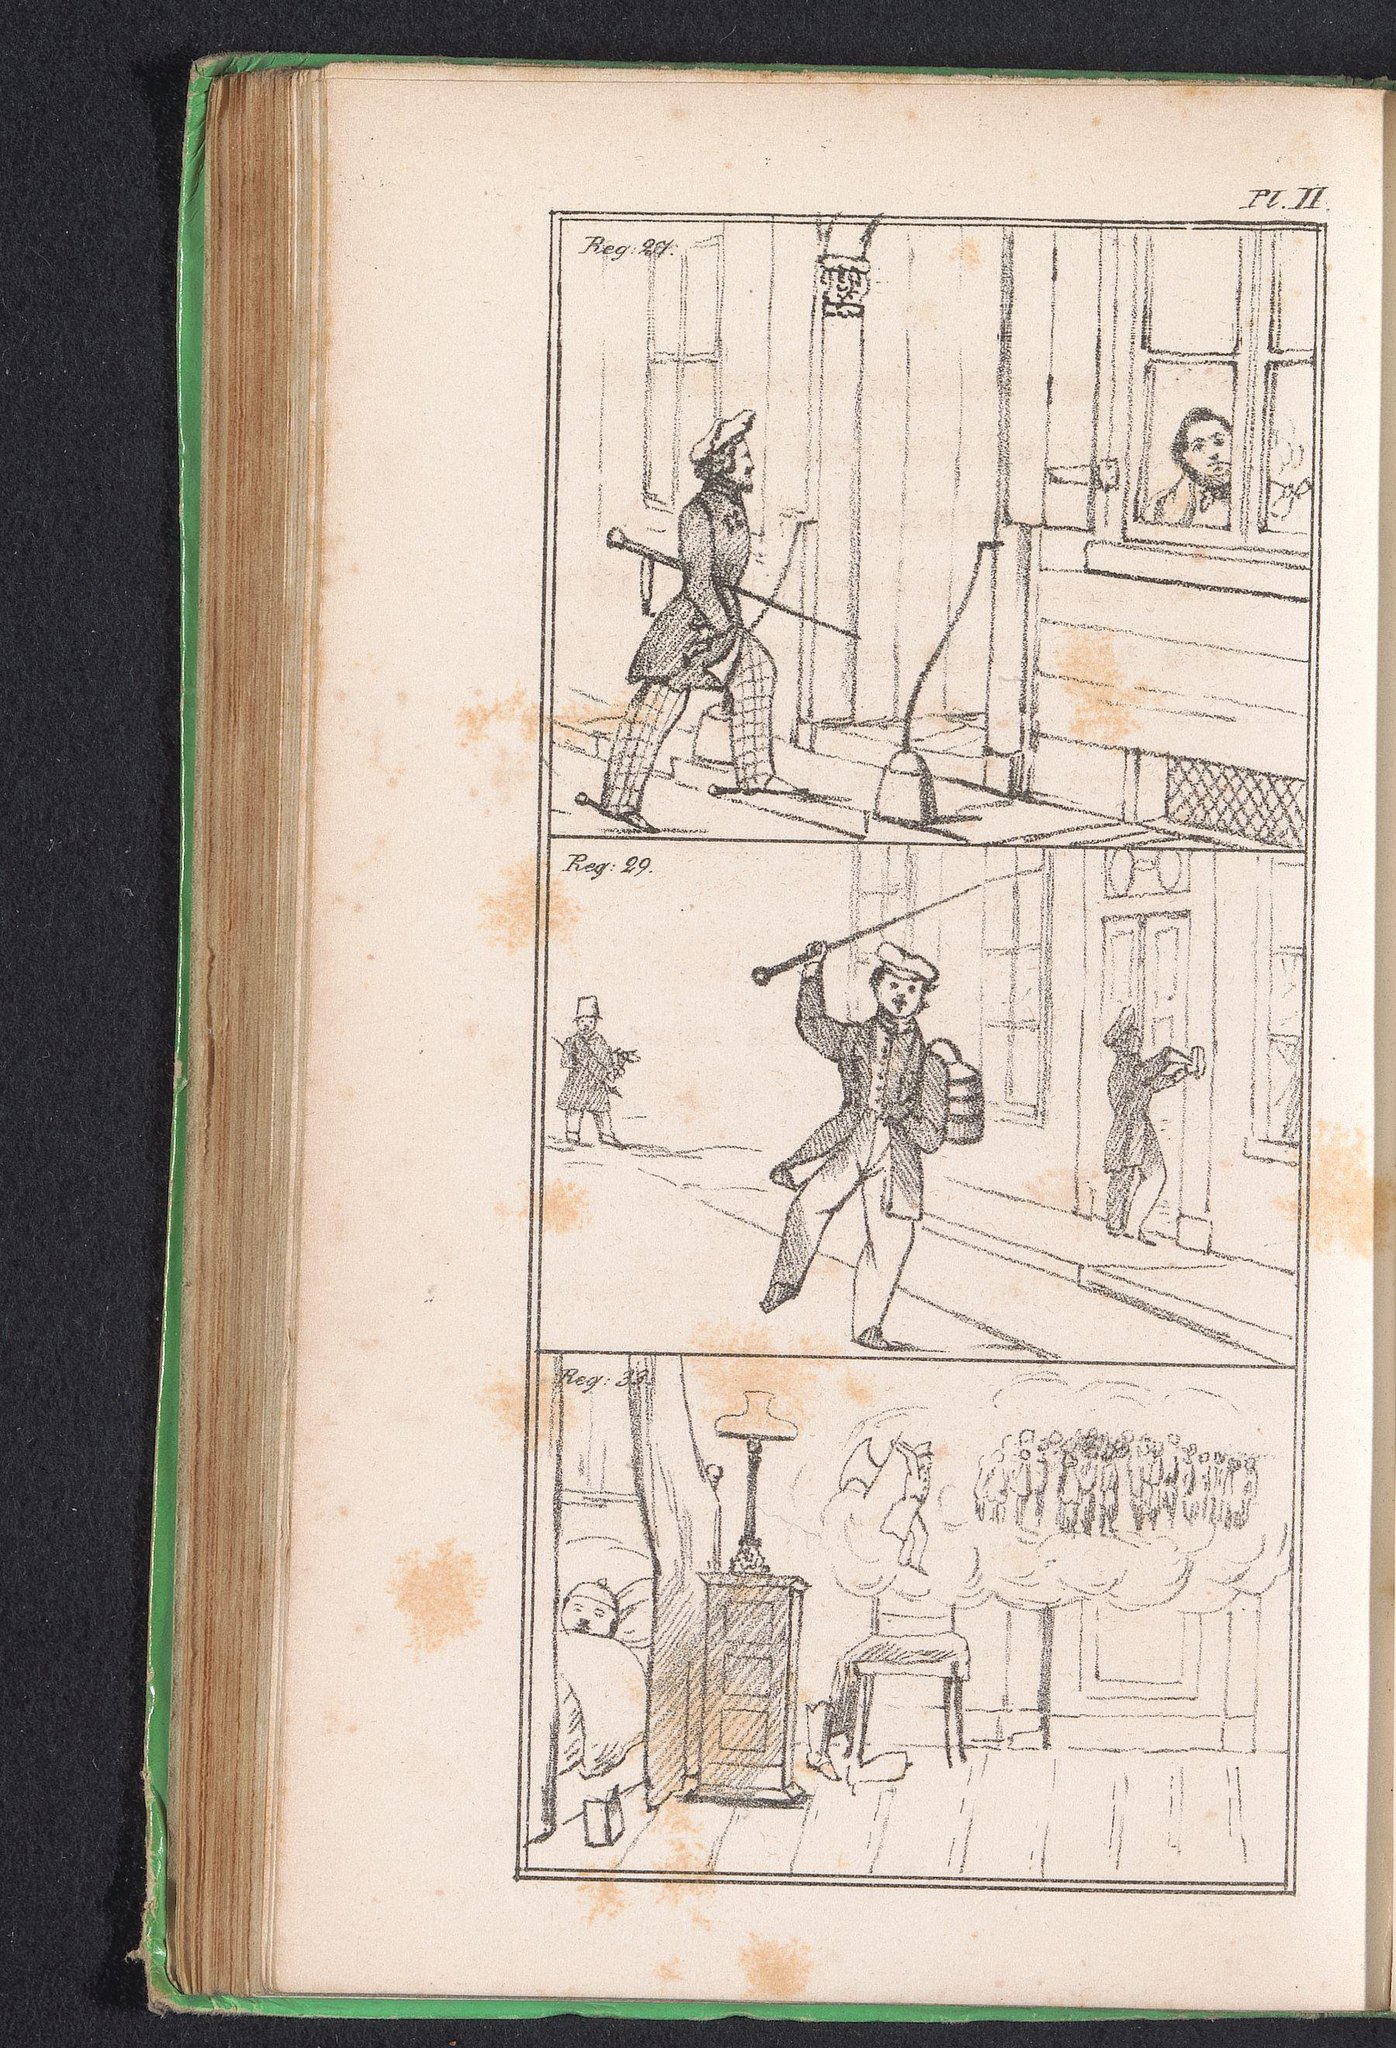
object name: print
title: Spotprent in Utrechtse studentenalmanak, 1842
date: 1842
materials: paper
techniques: lithograph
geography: netherlands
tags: student life, utrecht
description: Plaat II: drie voorstellingen onder elkaar van het studentenleven. Tweede van vier illustraties bij het gedicht 'De tijdperken van het studentenleven' van J.J.L. ten Kate. Spotprent in de studentenalmanak van de Universiteit van Utrecht van het jaar 1842.